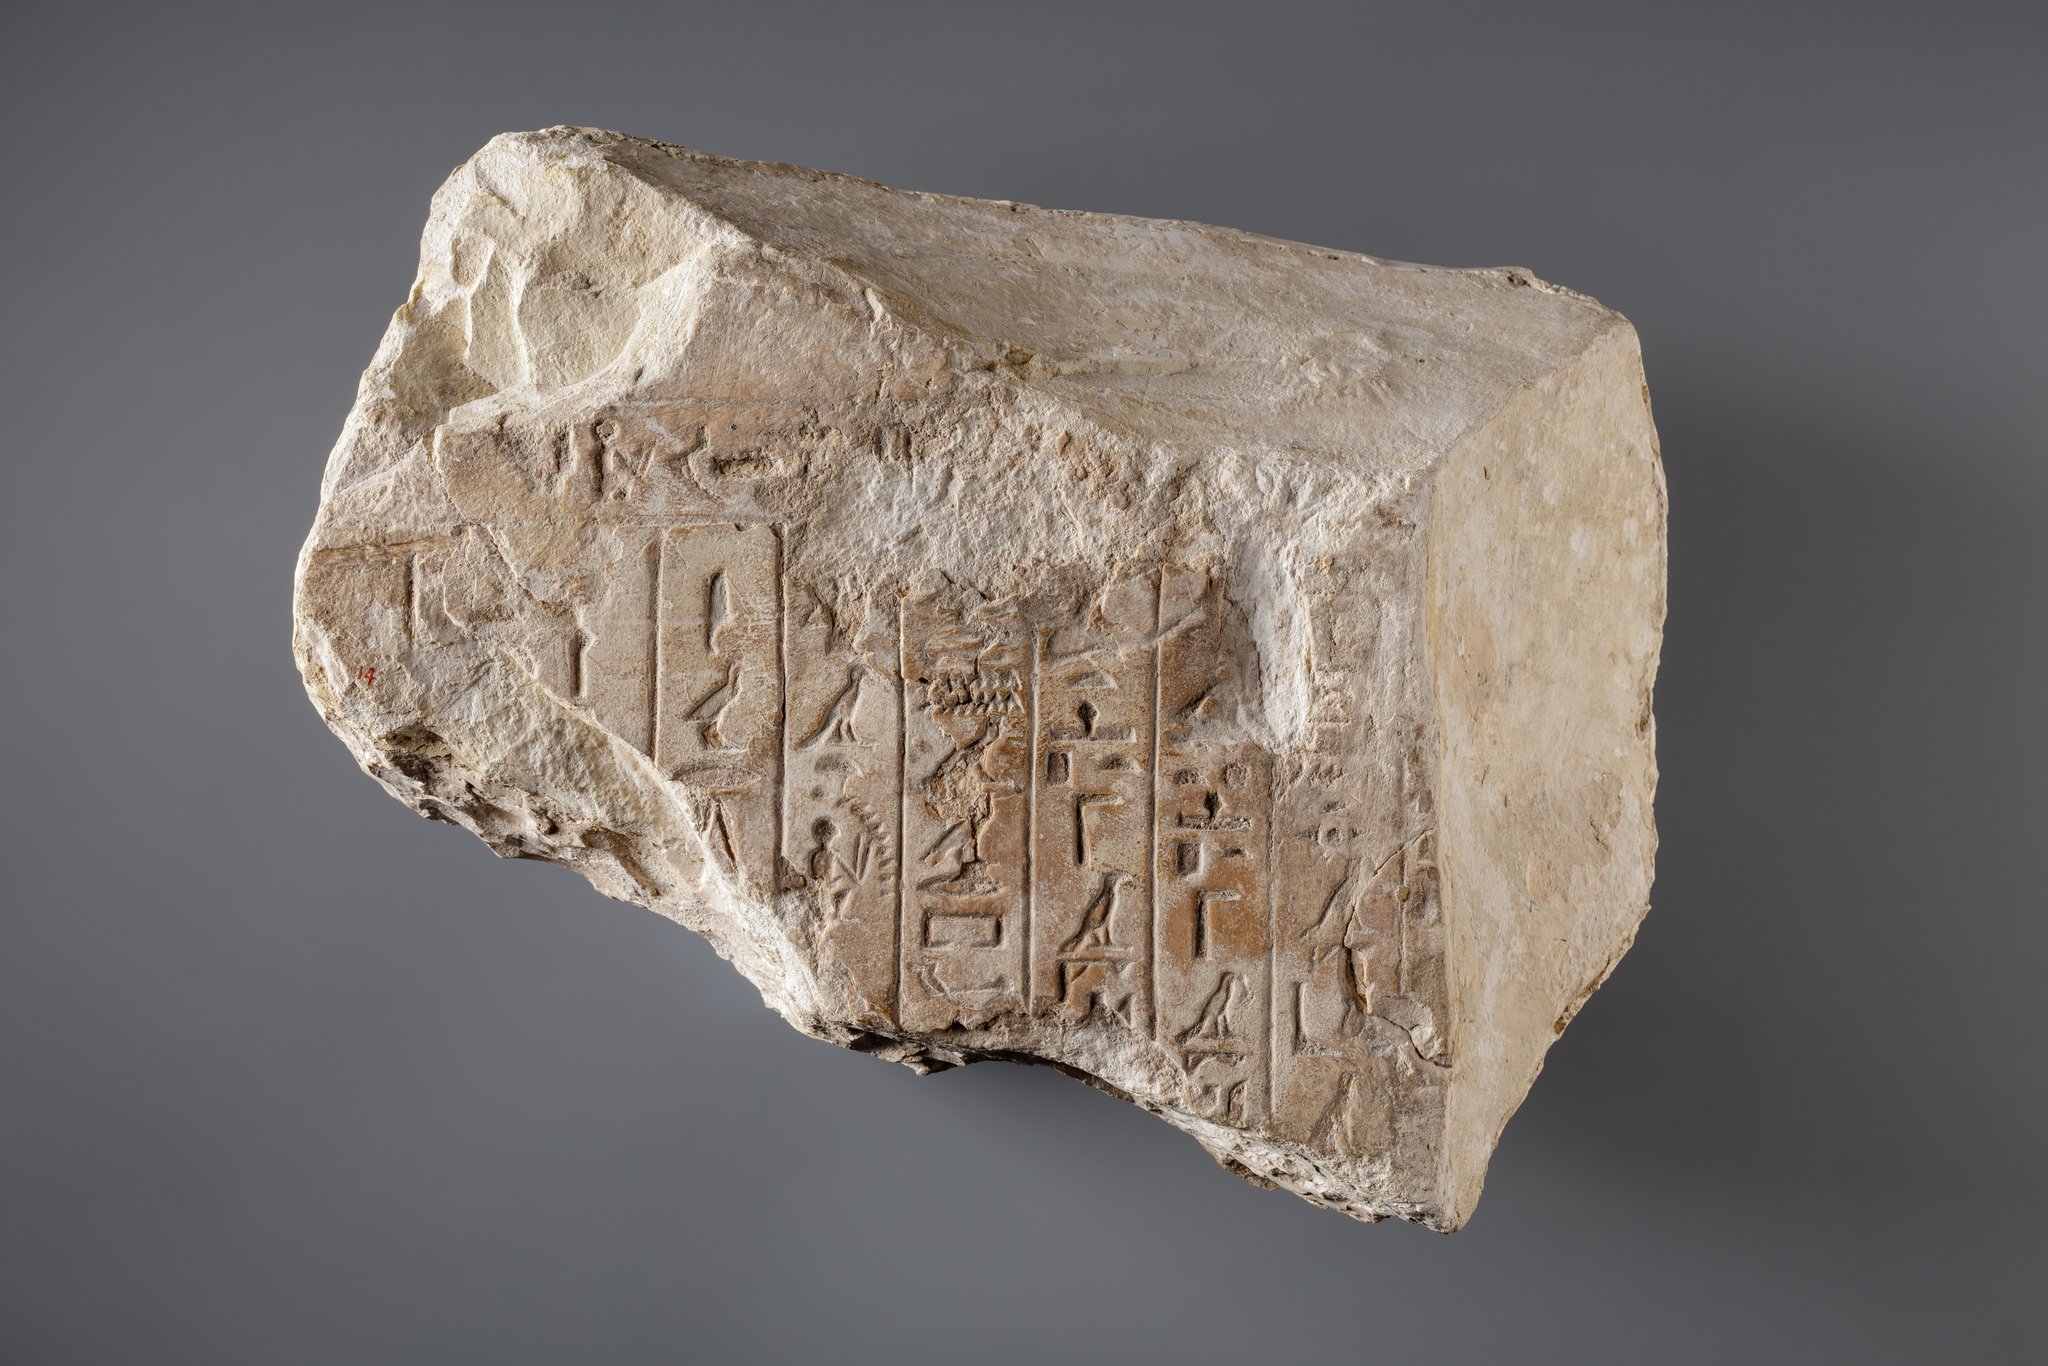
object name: relief, decree of horus khabau, king neferkaure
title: Fragment of decree of Horus Khabau, probably King Neferkaure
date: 2107-2103 BCE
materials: limestone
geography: egypt